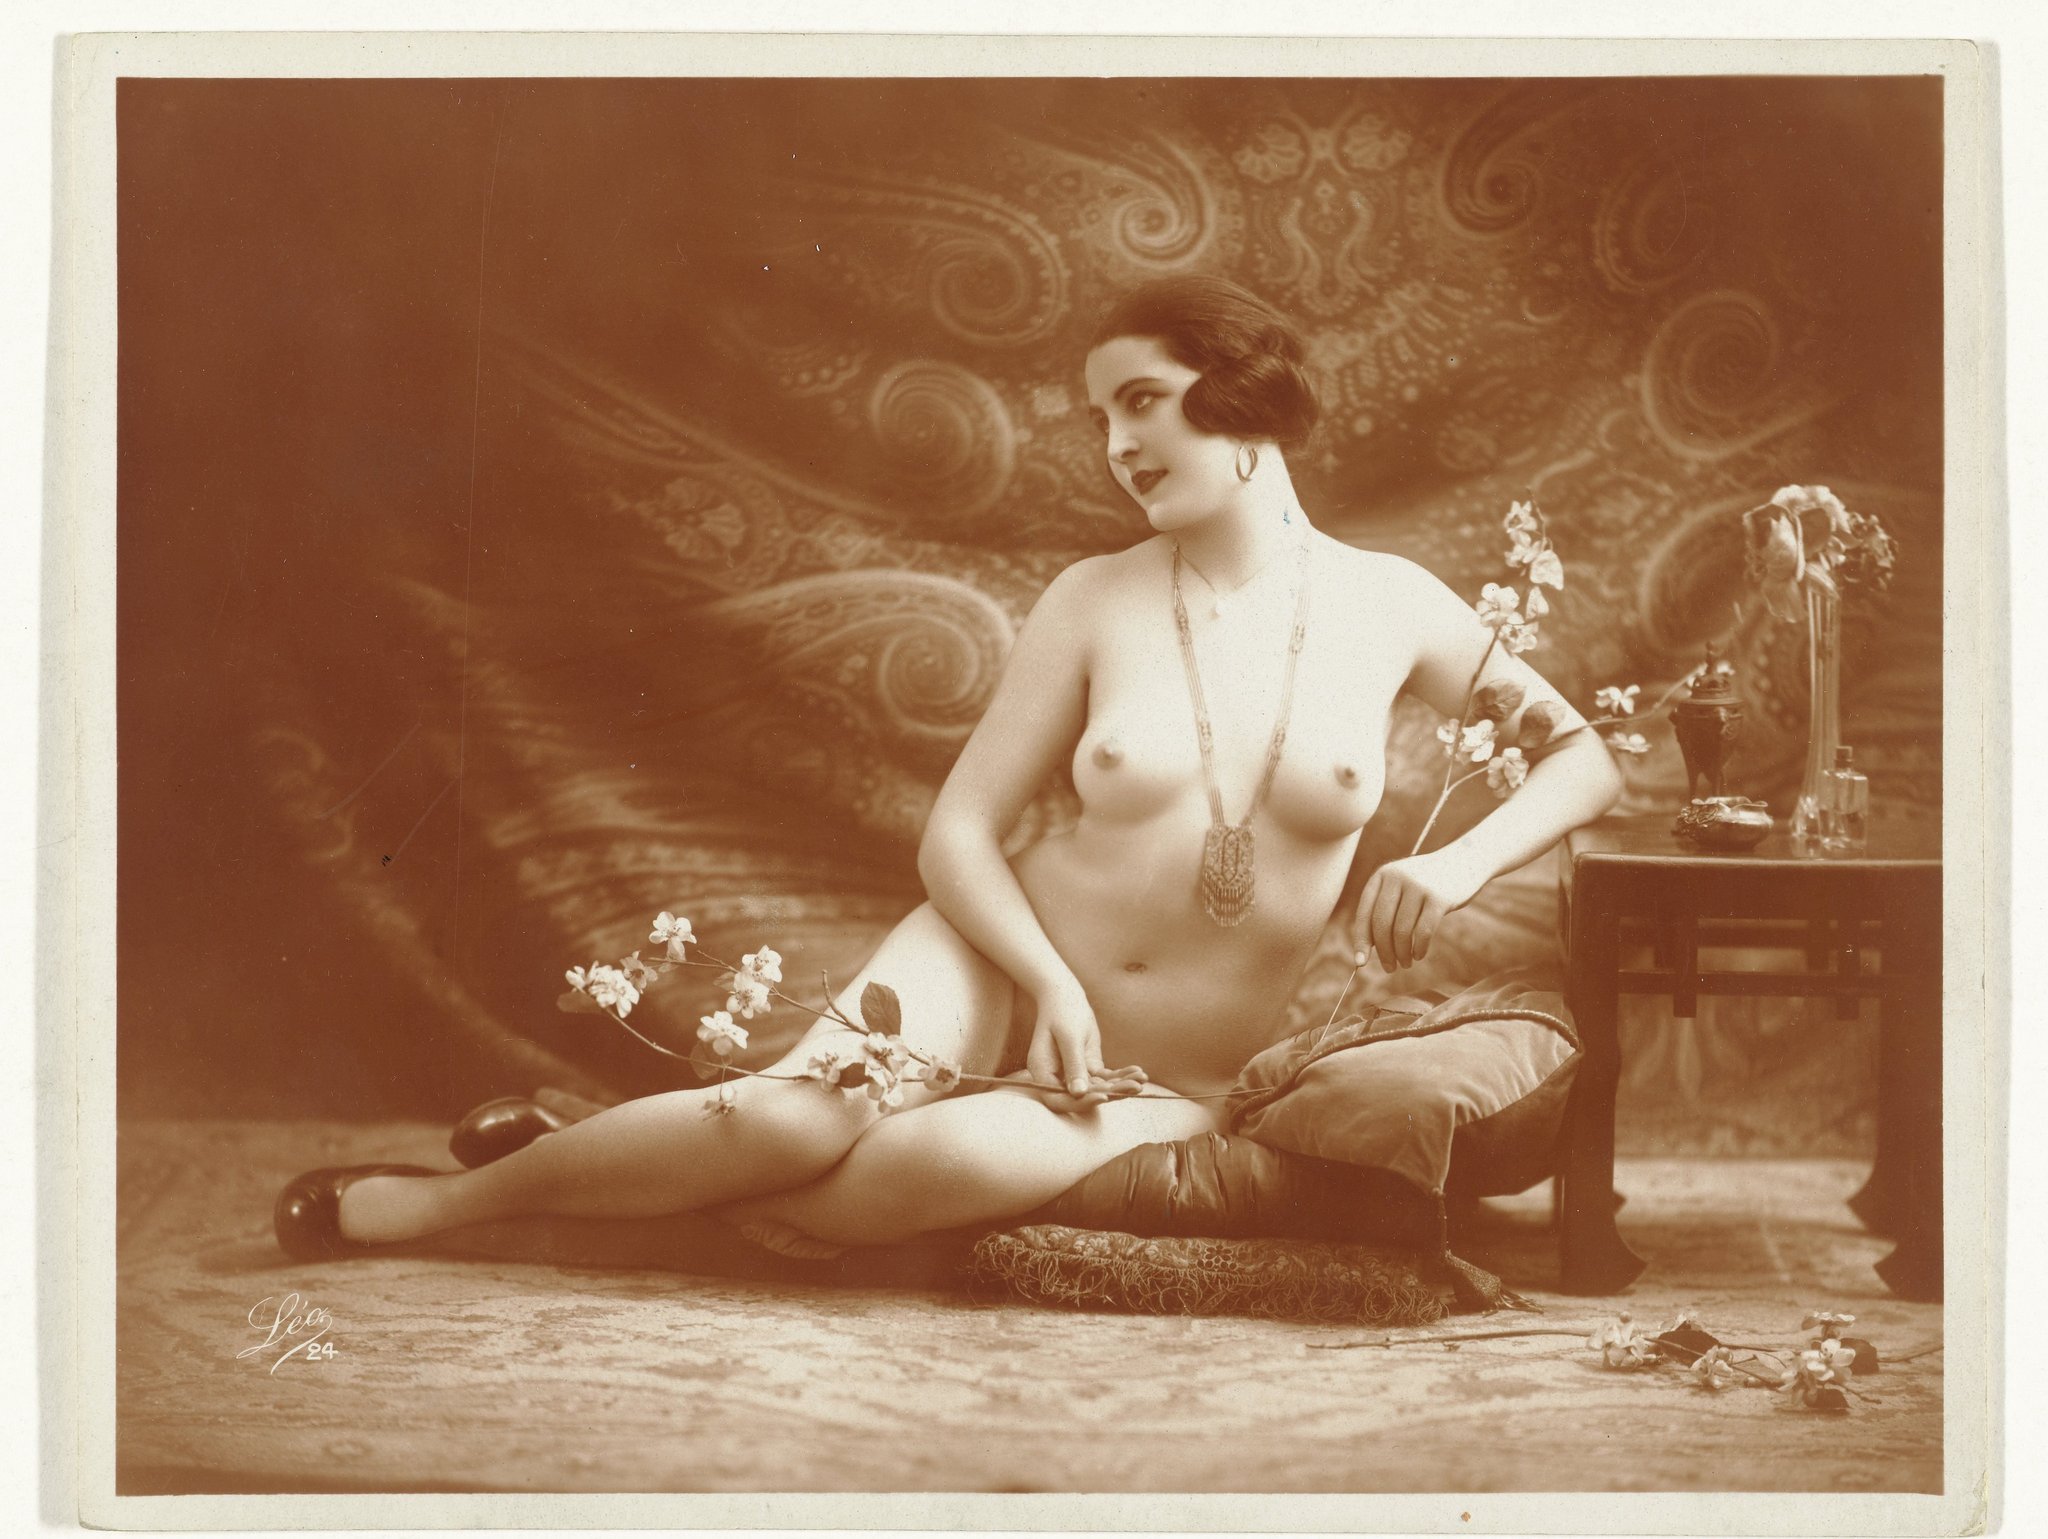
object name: photograph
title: Vrouwelijk naakt met bloemen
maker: léo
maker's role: fotograaf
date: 1900-1920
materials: paper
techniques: gelatin silver print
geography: france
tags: the (nude) human figure; 'corpo humano' (ripa) - aa - female human figure, necklace, france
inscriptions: inscription: ‘Spiegelen/ dubbele paginabr./ 1x406 mm/ pag 8/9/ 1x30mm pag. 3’, number: ‘24’, inscription: ‘Gereproduceerd in Sextant (blad/ van NVSH) aug. 1973 p3 en p8/9’